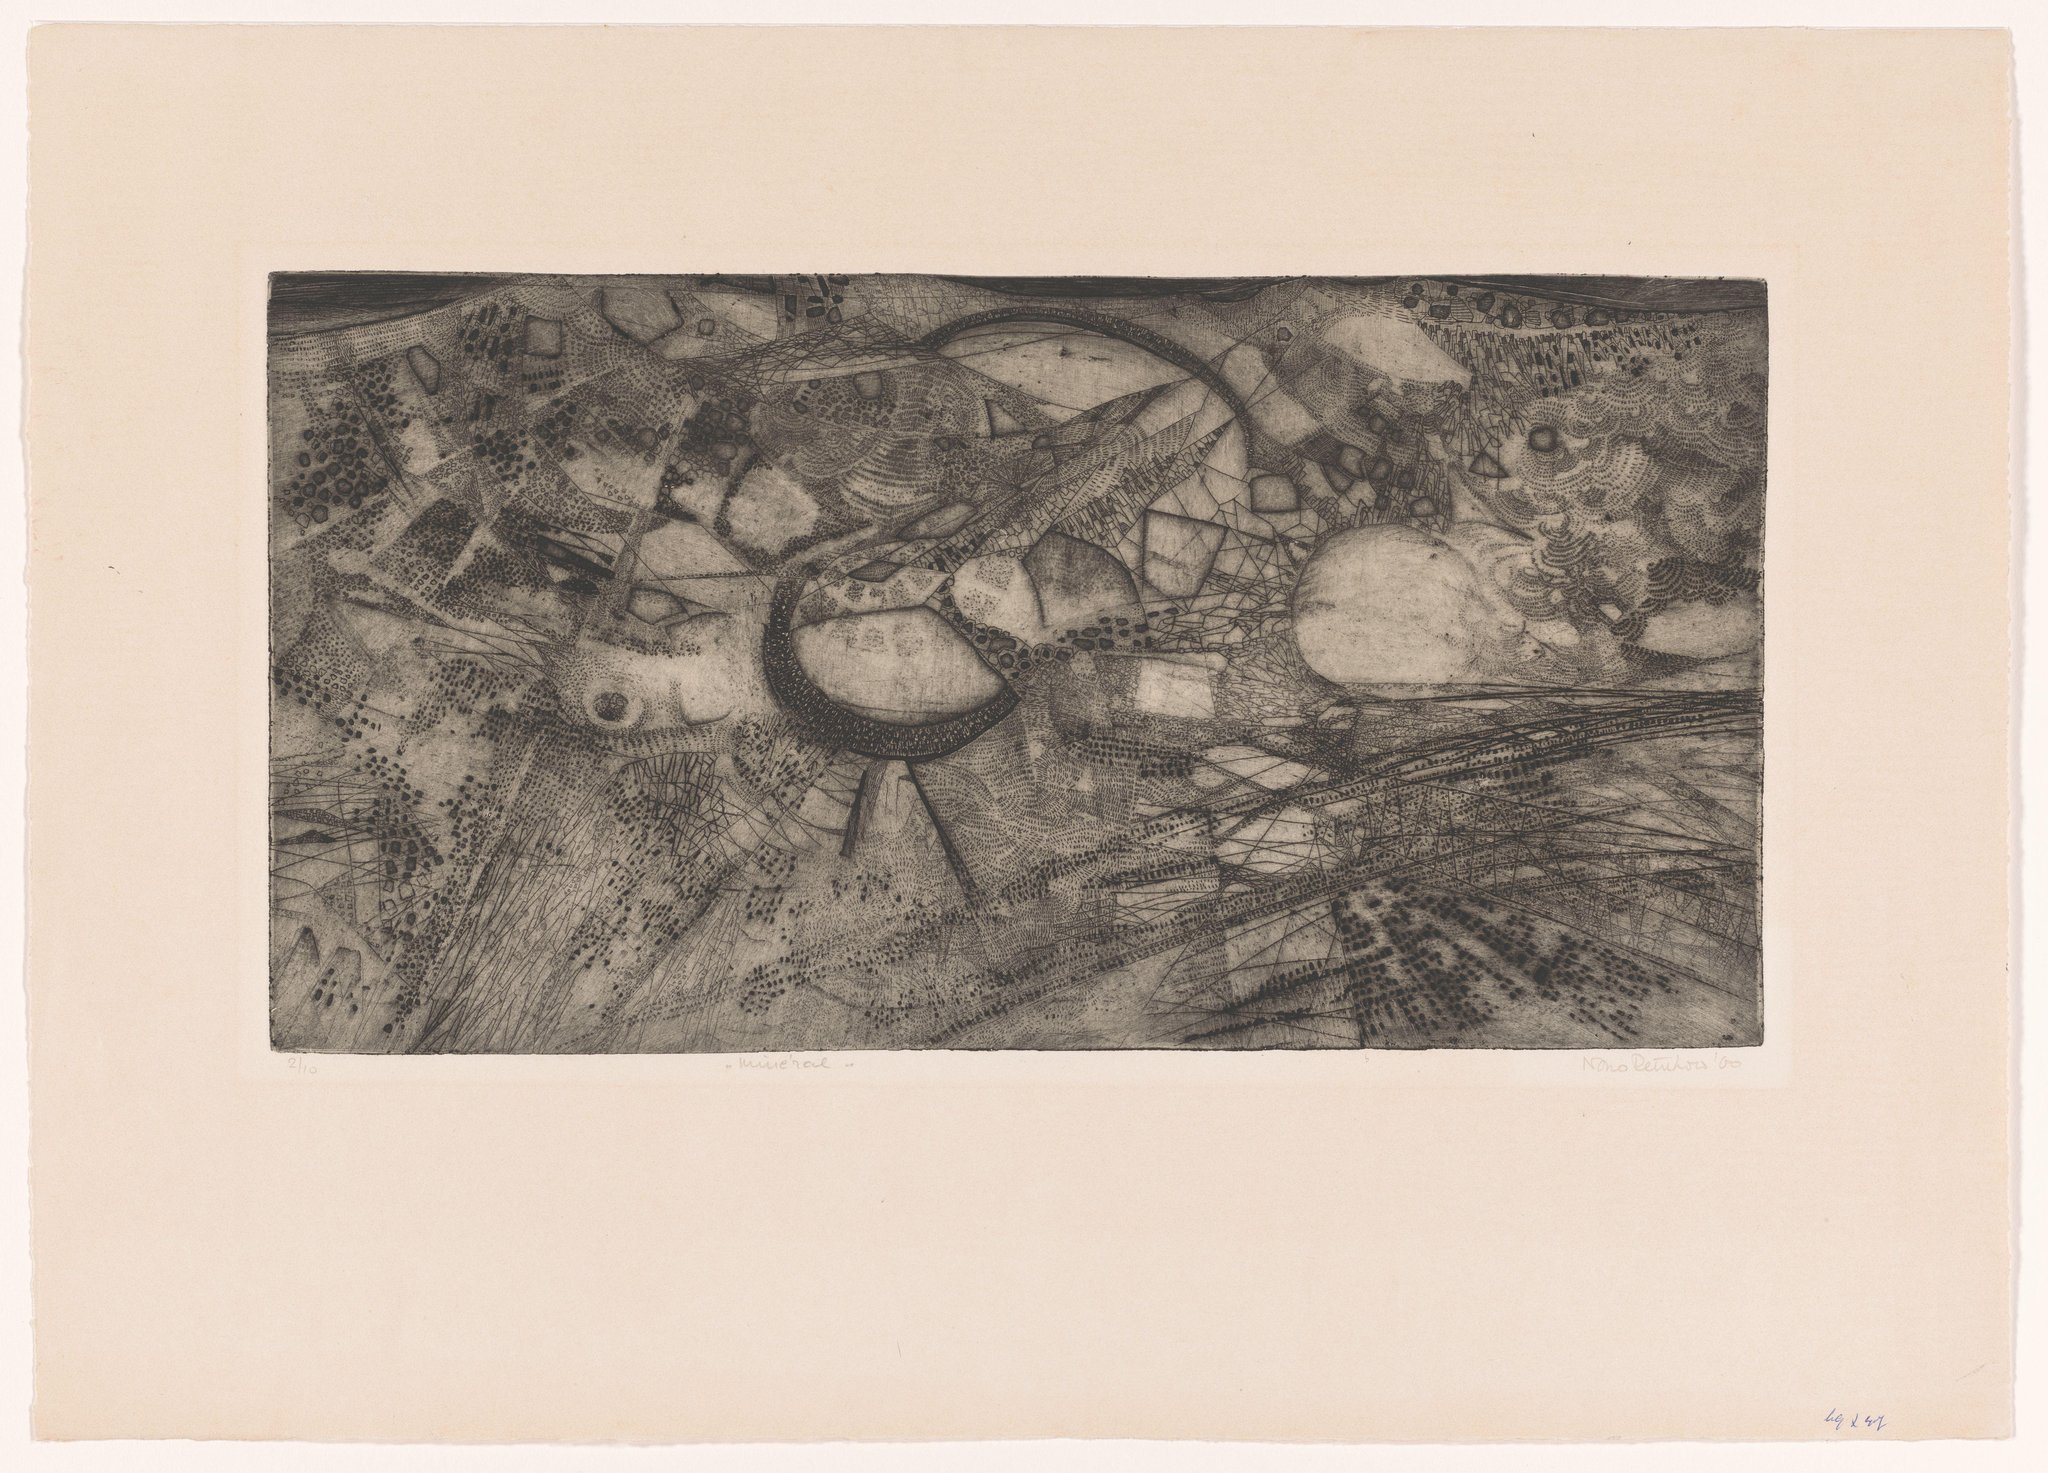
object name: print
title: Minéral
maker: nono reinhold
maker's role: print maker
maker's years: 1929-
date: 1960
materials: paper, ink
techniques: aquatint, drypoint, etching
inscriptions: signature and date: ‘Nono Reinhold '60’, edition: ‘2/10’, title: ‘"Minéral"’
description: Surrealistische compositie bestaande uit lijnen, stippen en kleine vormen.